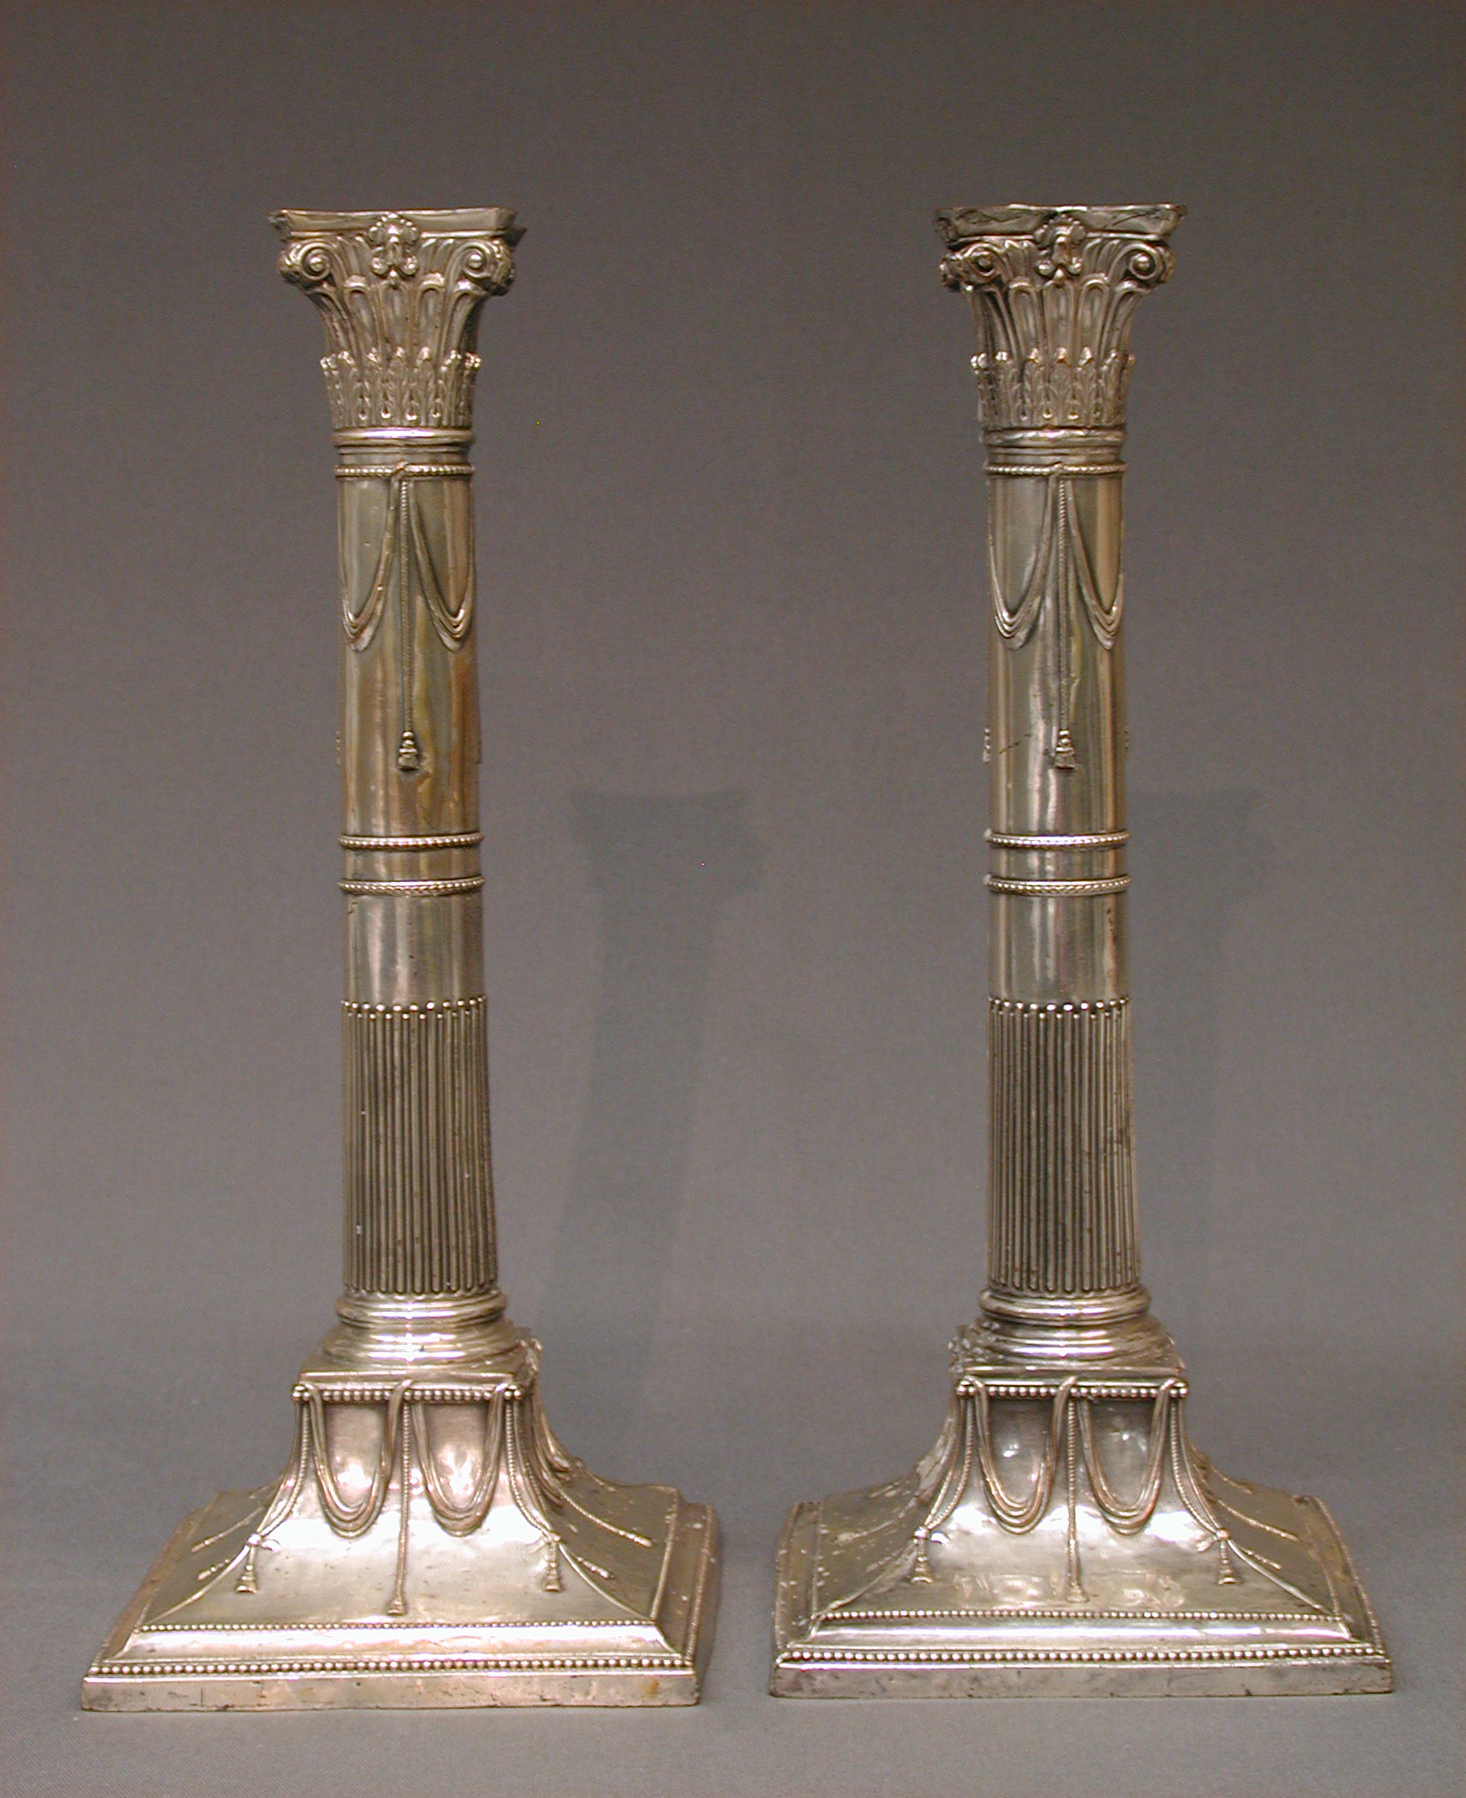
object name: candlestick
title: Pair of candlesticks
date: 1775-1780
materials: metal